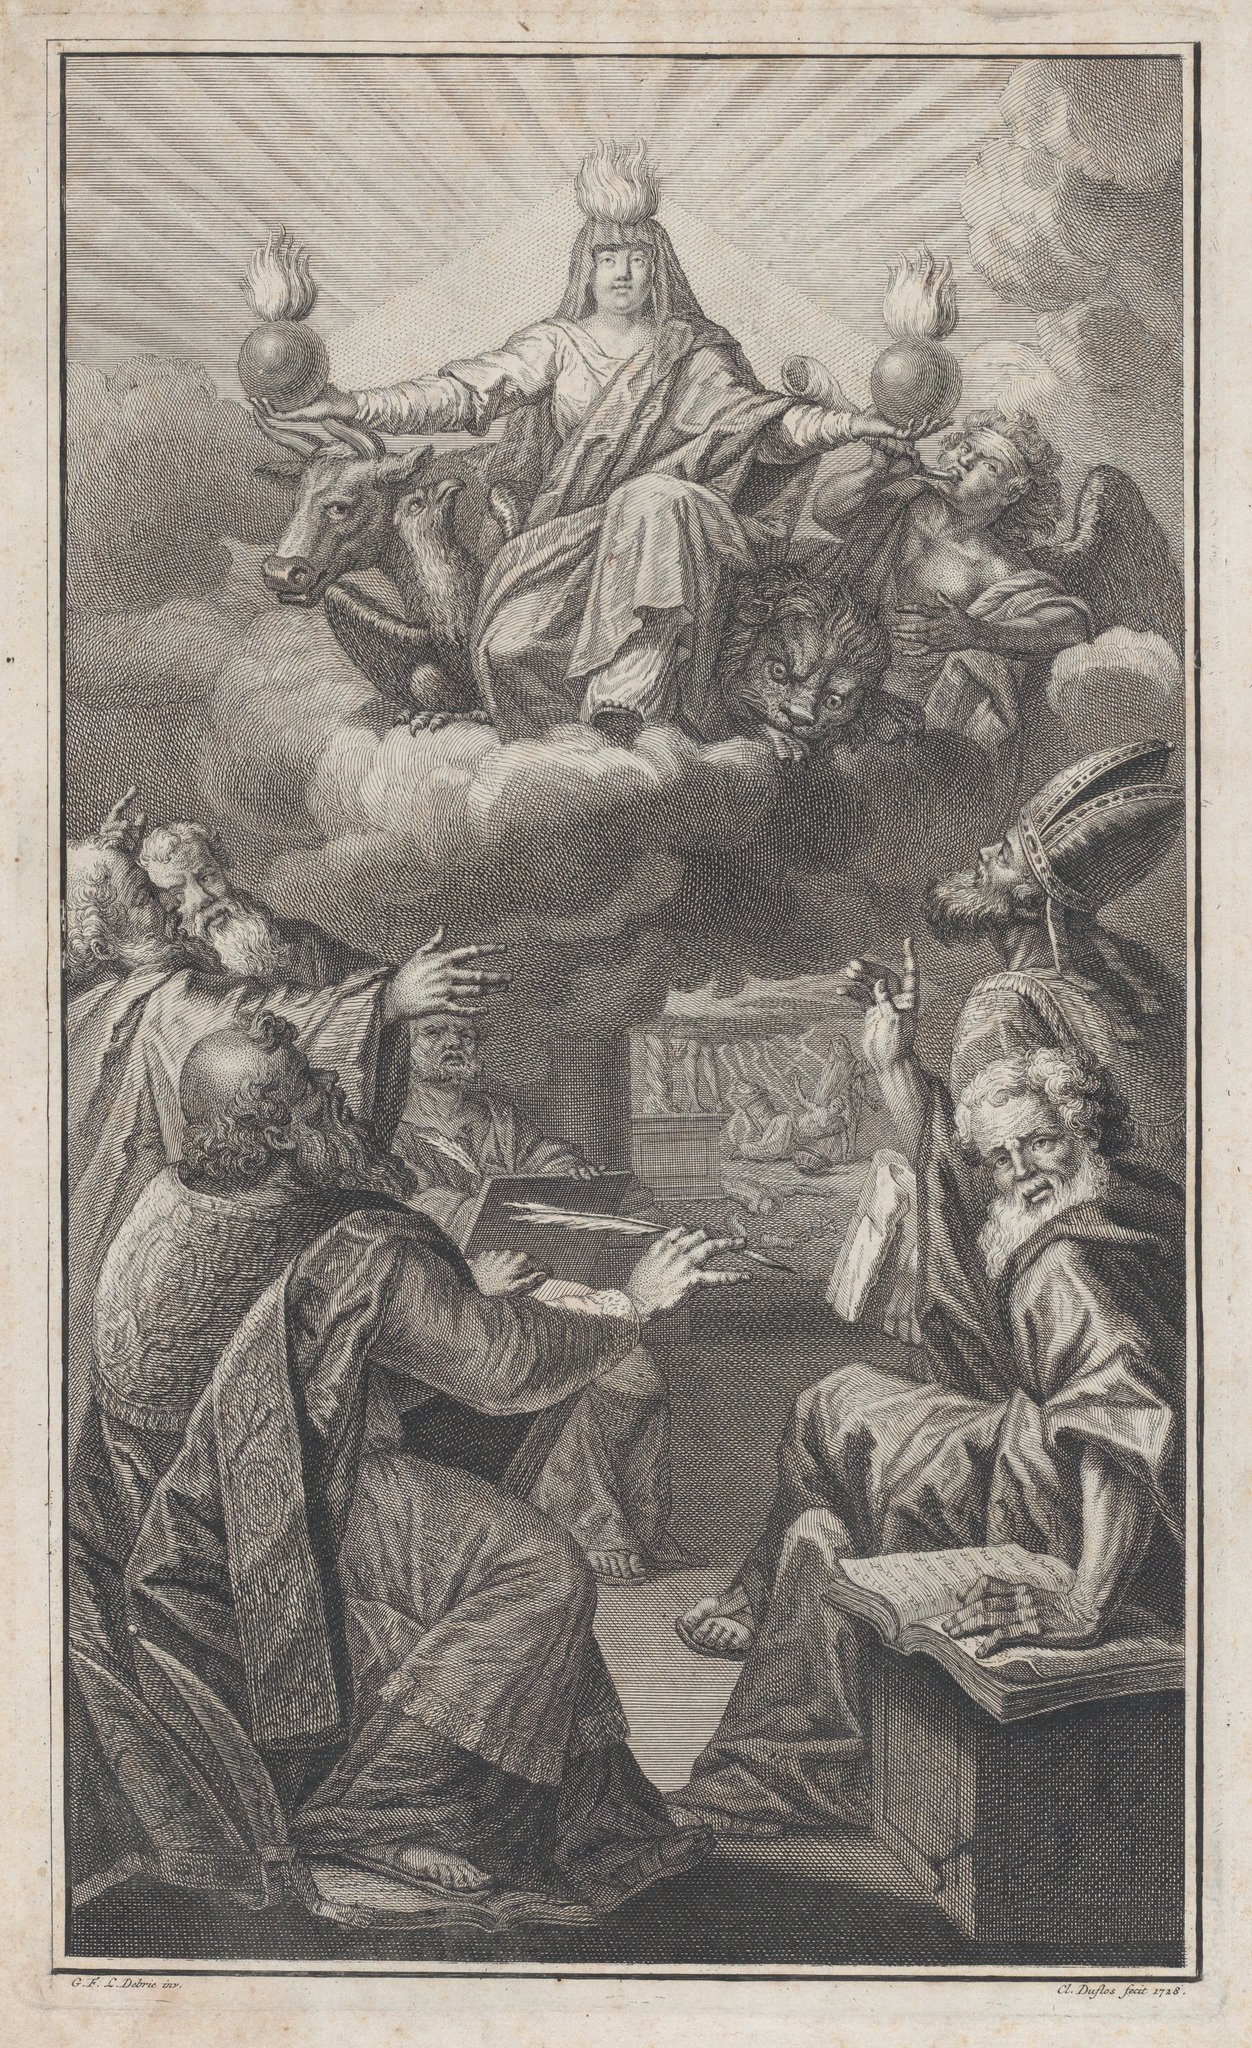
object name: print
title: Allegorical figure appearing on clouds overhead while a group of men gathered below look up in astonishment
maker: claude augustin duflos le jeune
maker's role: artist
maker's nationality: french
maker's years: 1700-1786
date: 1728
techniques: etching